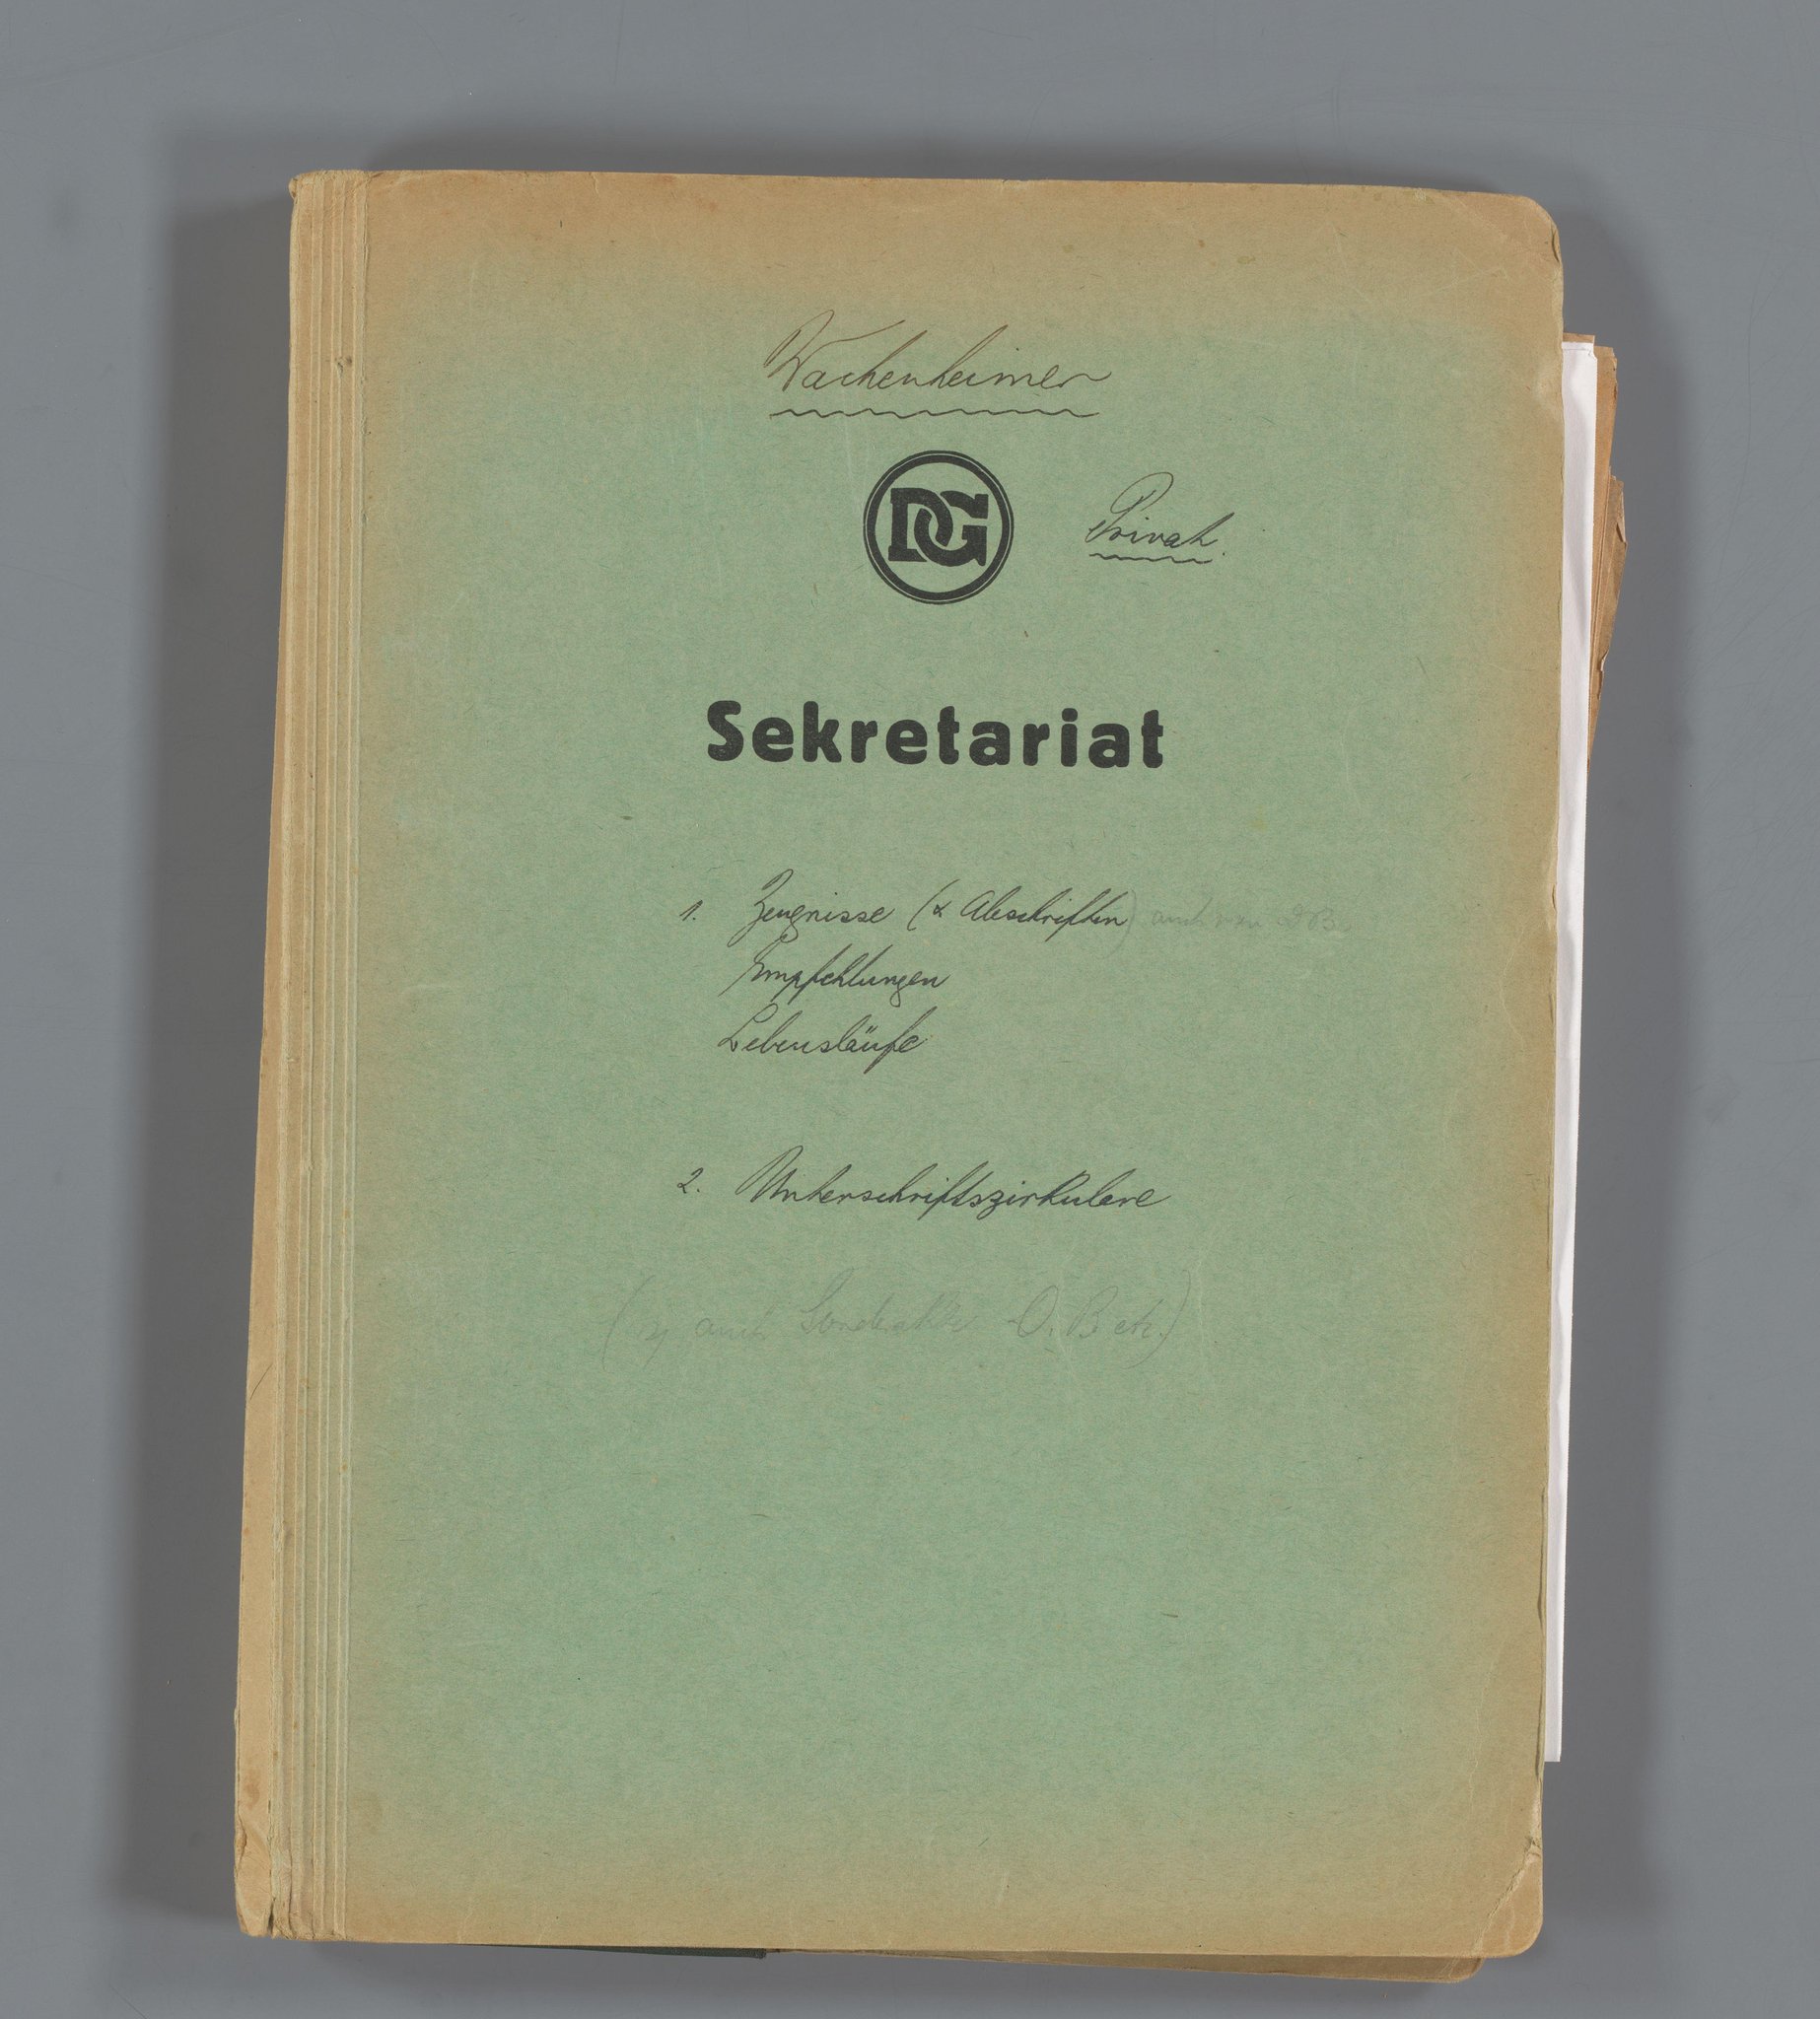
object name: testimonial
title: Getuigschriften Eugen Wachenheimer over werkzaamheden in bankwezen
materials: paper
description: Dit object is onderdeel van de nalatenschap van Isabel Elon-Wachenheimer (1928-2010). Tot haar overlijden behoorde het samen met de andere objecten uit de nalatenschap tot haar privédomein van Isabel Wachenheimer. In die particuliere context zijn deze objecten tezamen en individueel aandenkens - aan de jeugd, ouders en familie van Isabel Wachenheimer vóór en tijdens de Shoah en aan haar leven na de Tweede Wereldoorlog. Isabel Wachenheimer, die van juni 1943 tot mei 1945 gevangen zat in Kamp Westerbork, Theresienstadt, Auschwitz, Lenzing a/d Oberdonau (een buitenkamp van Mauthausen), overleefde de Shoah. Haar ouders – Eugène Wachenheimer en Else Wachenheimer-Moos - werden op 14 oktober 1944 in Auschwitz-Birkenau vermoord.